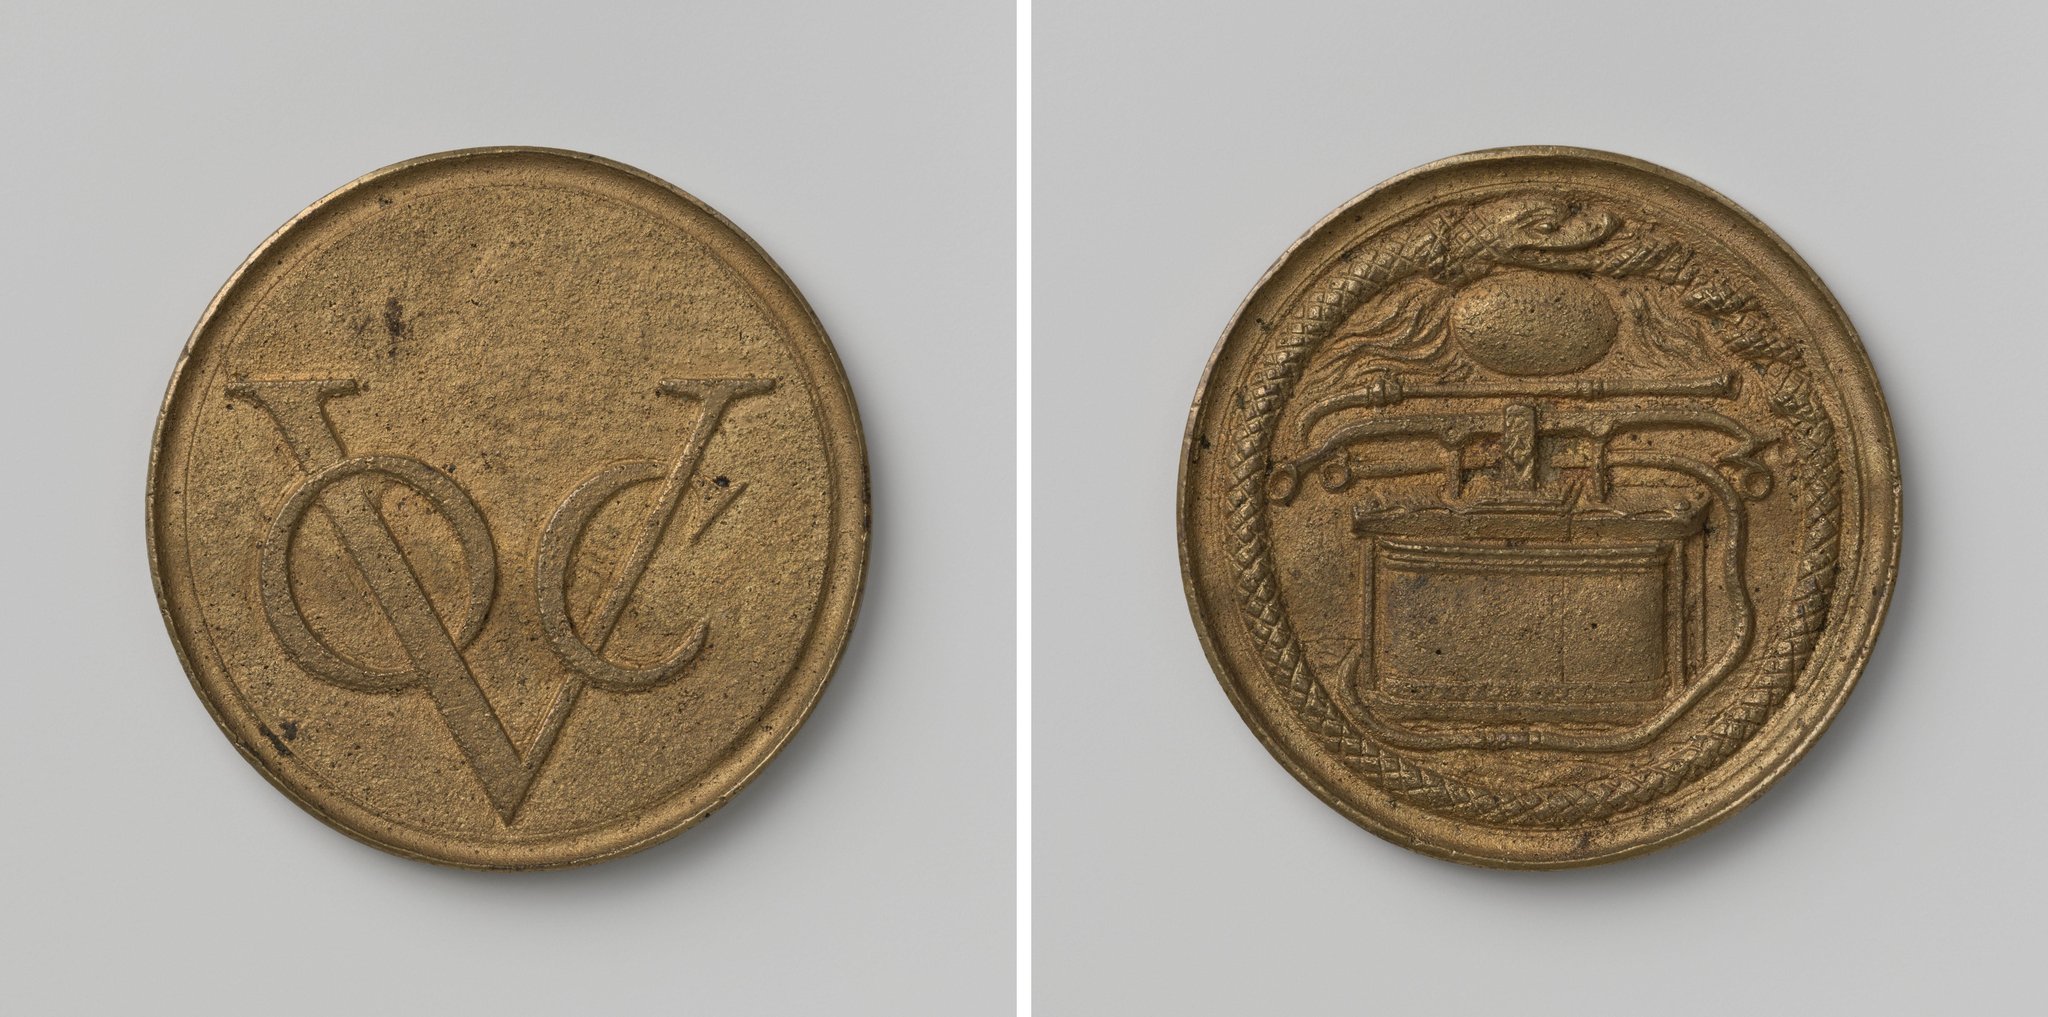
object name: medal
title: Verenigde Oostindische Compagnie, kamer Amsterdam, brandspuitpenning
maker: Anonymous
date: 1680-1799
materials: brass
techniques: casting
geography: amsterdam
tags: amsterdam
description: Messing penning. Voorzijde: monogram van letters V, O en C. Keerzijde: brandspuit onder leeg cartouche binnen slangerond.